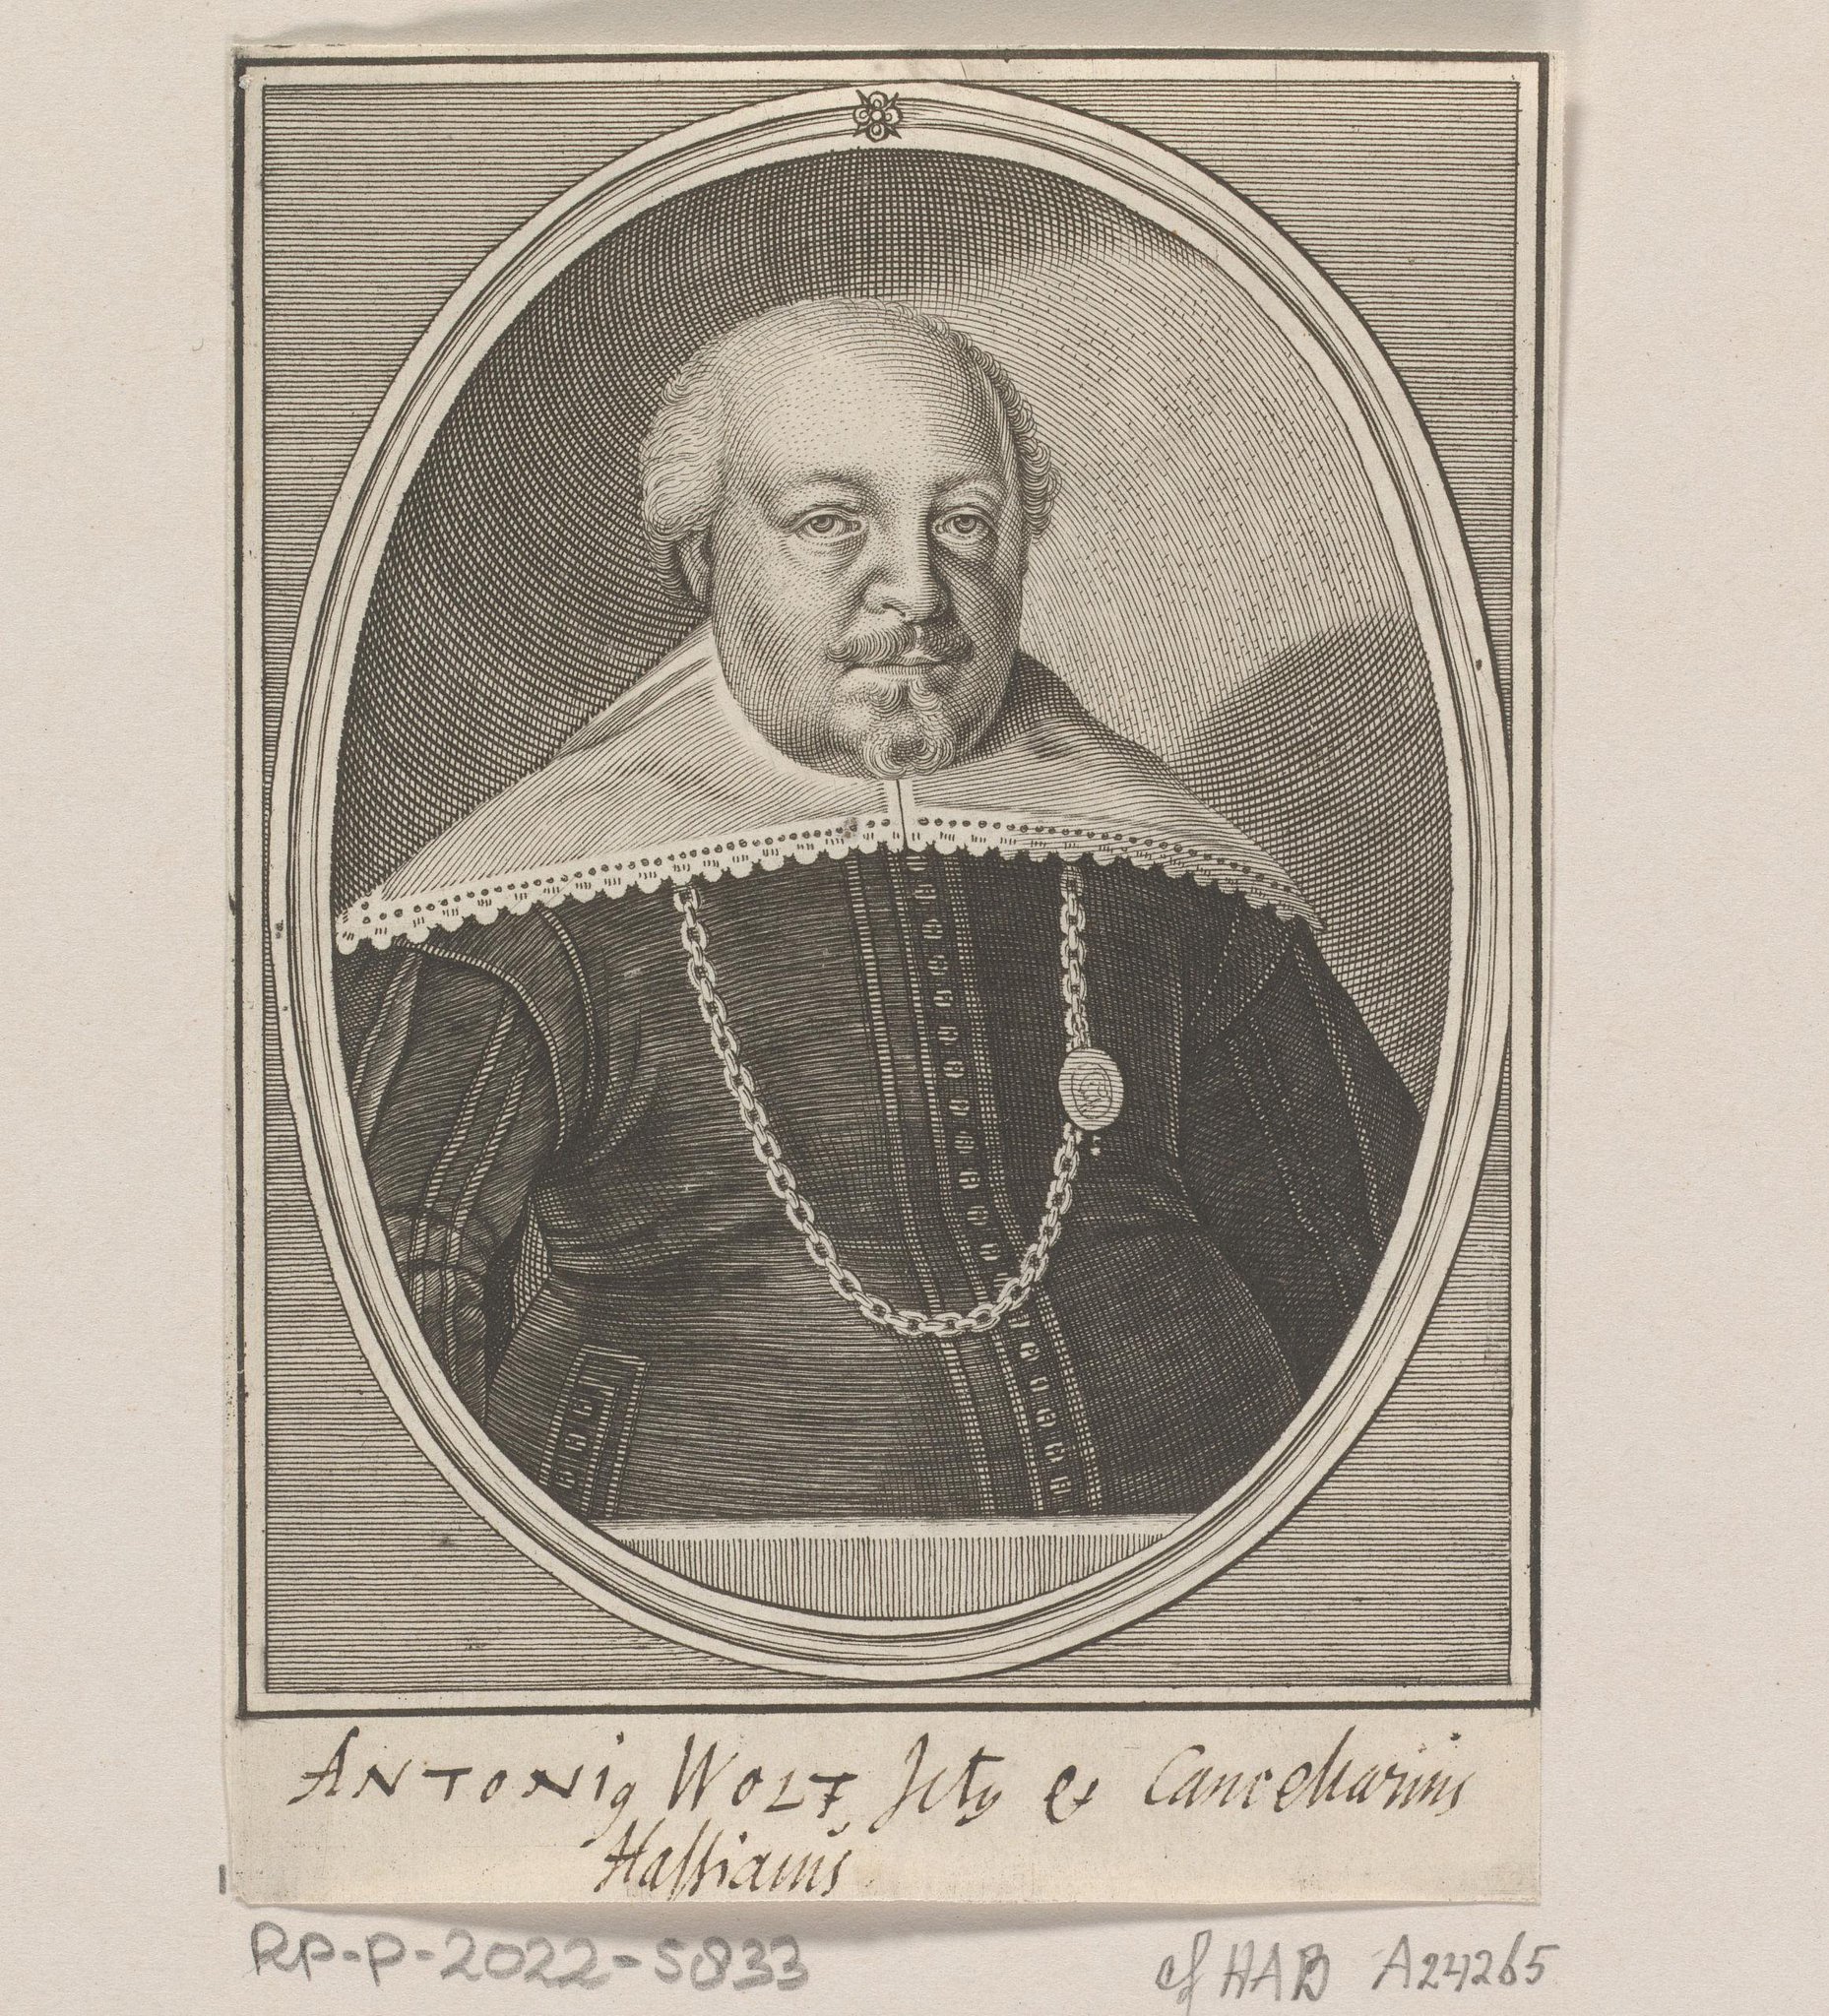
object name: print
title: Portret van Anton Wolff von Todenwarth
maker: sebastian furck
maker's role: print maker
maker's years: 1600-1655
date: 1637-1639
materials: paper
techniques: engraving, etching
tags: governmental and representative bodies, historical persons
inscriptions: inscription: ‘Antoni Wolf [...] cancellarius Halsianis’